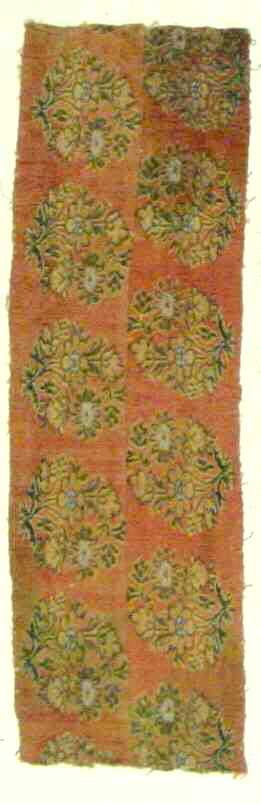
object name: textile fragment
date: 1601-1800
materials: silk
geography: iran